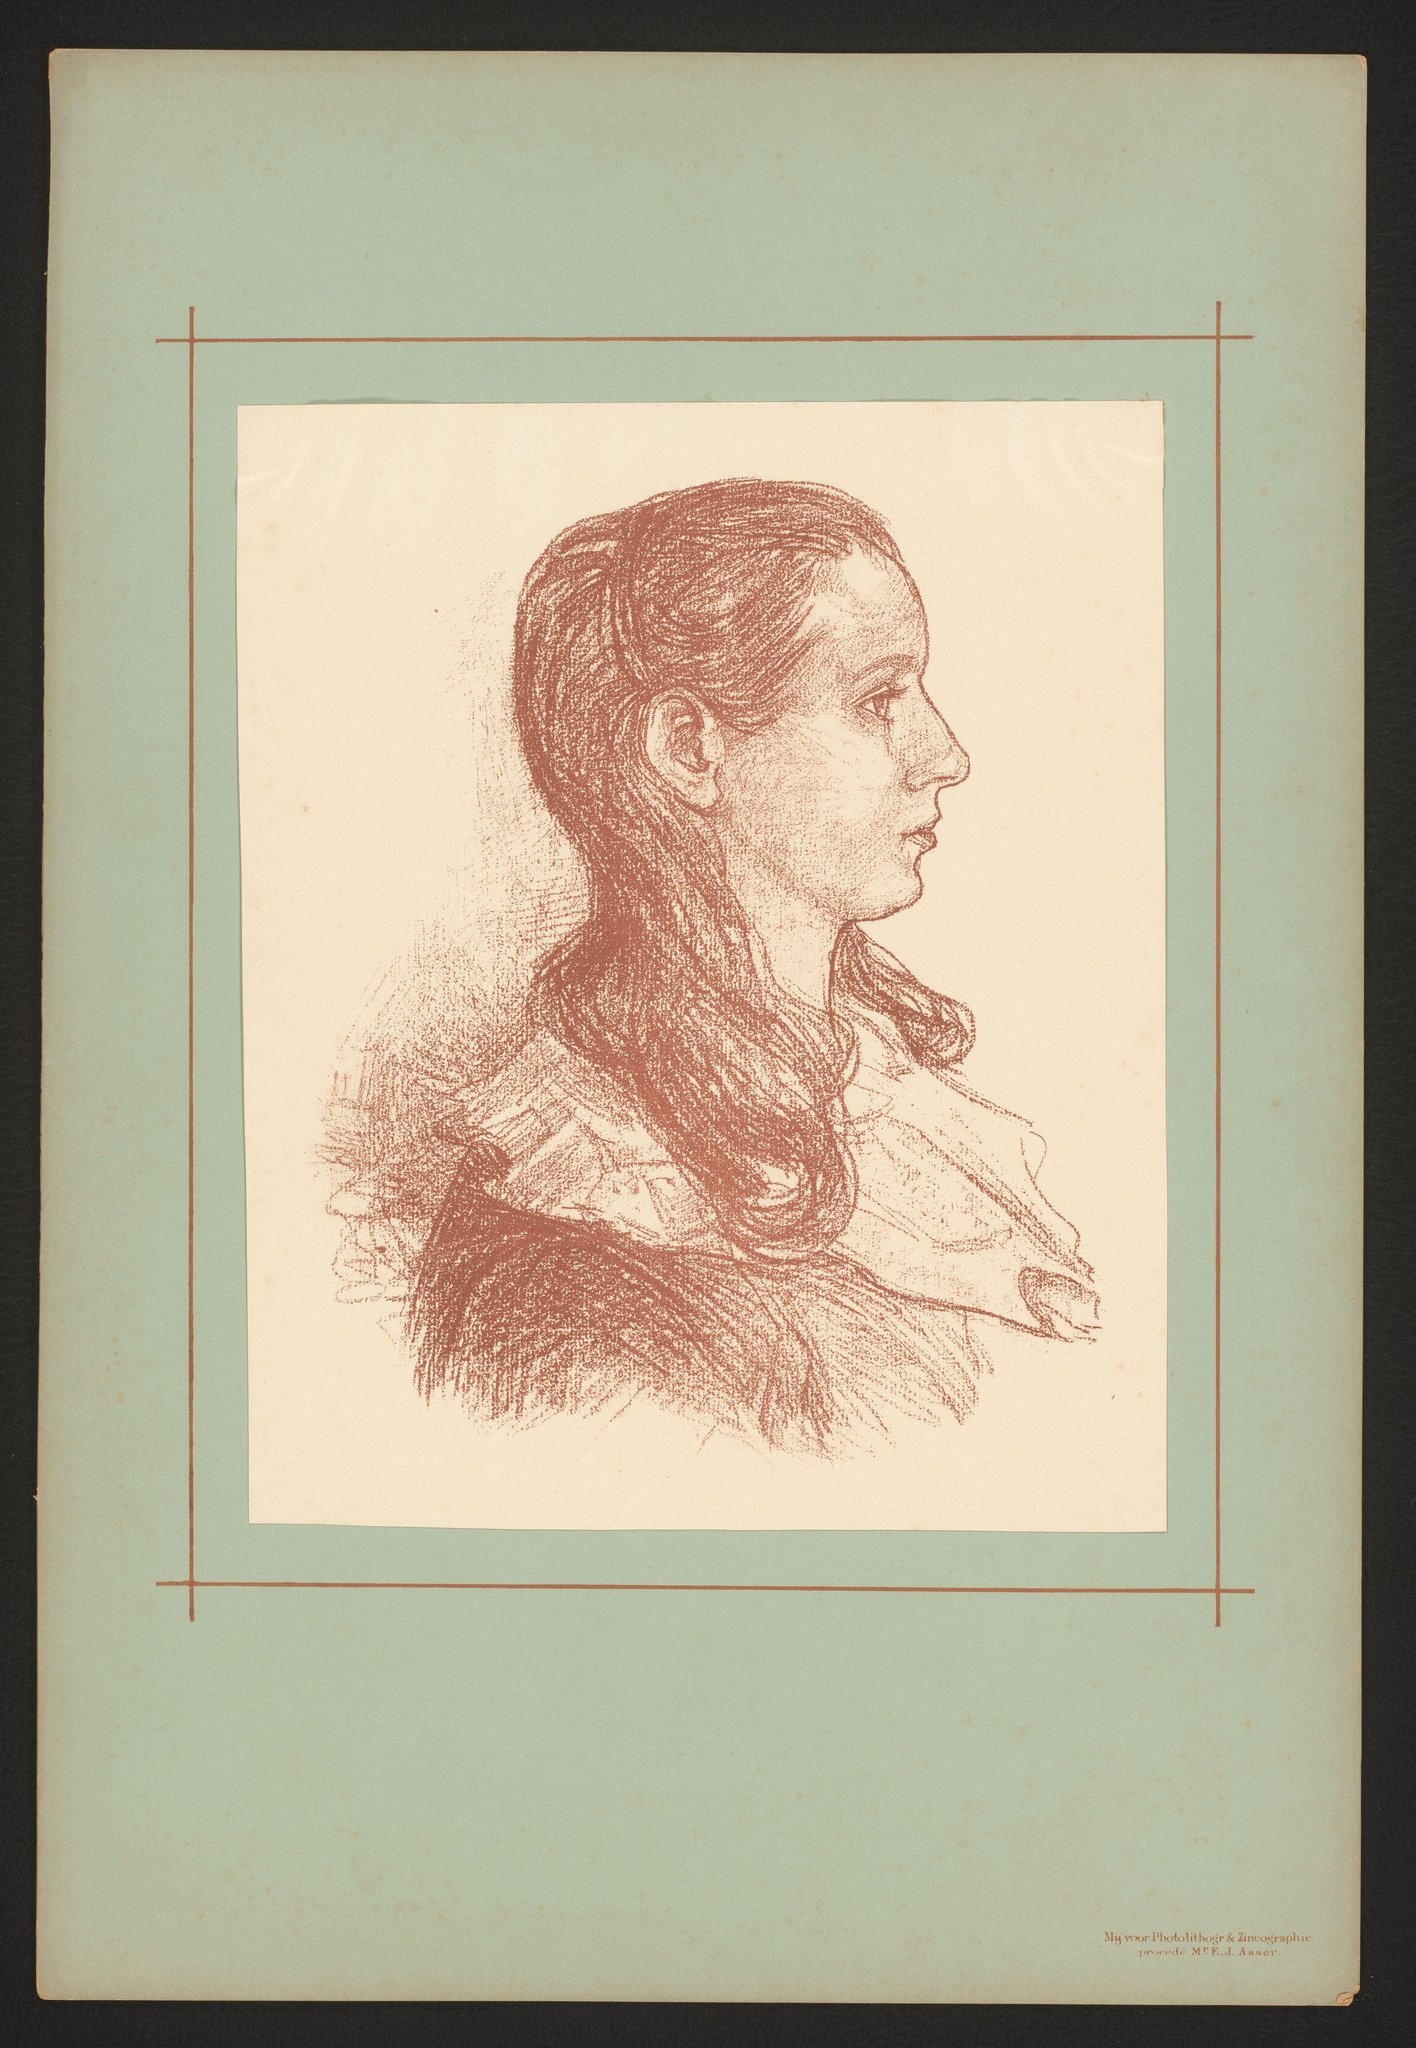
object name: reproduction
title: Fotoreproductie van een tekening, portret van een jonge vrouw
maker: Anonymous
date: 1892-1900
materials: paper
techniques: photolithography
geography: amsterdam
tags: adolescent, young woman, maiden, anonymous historical person portrayed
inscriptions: inscription: ‘Mij. voor Photolithogr & Zincographie/ procédé Mr. E.J. Asser.’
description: Deze prent maakt deel uit van een album.